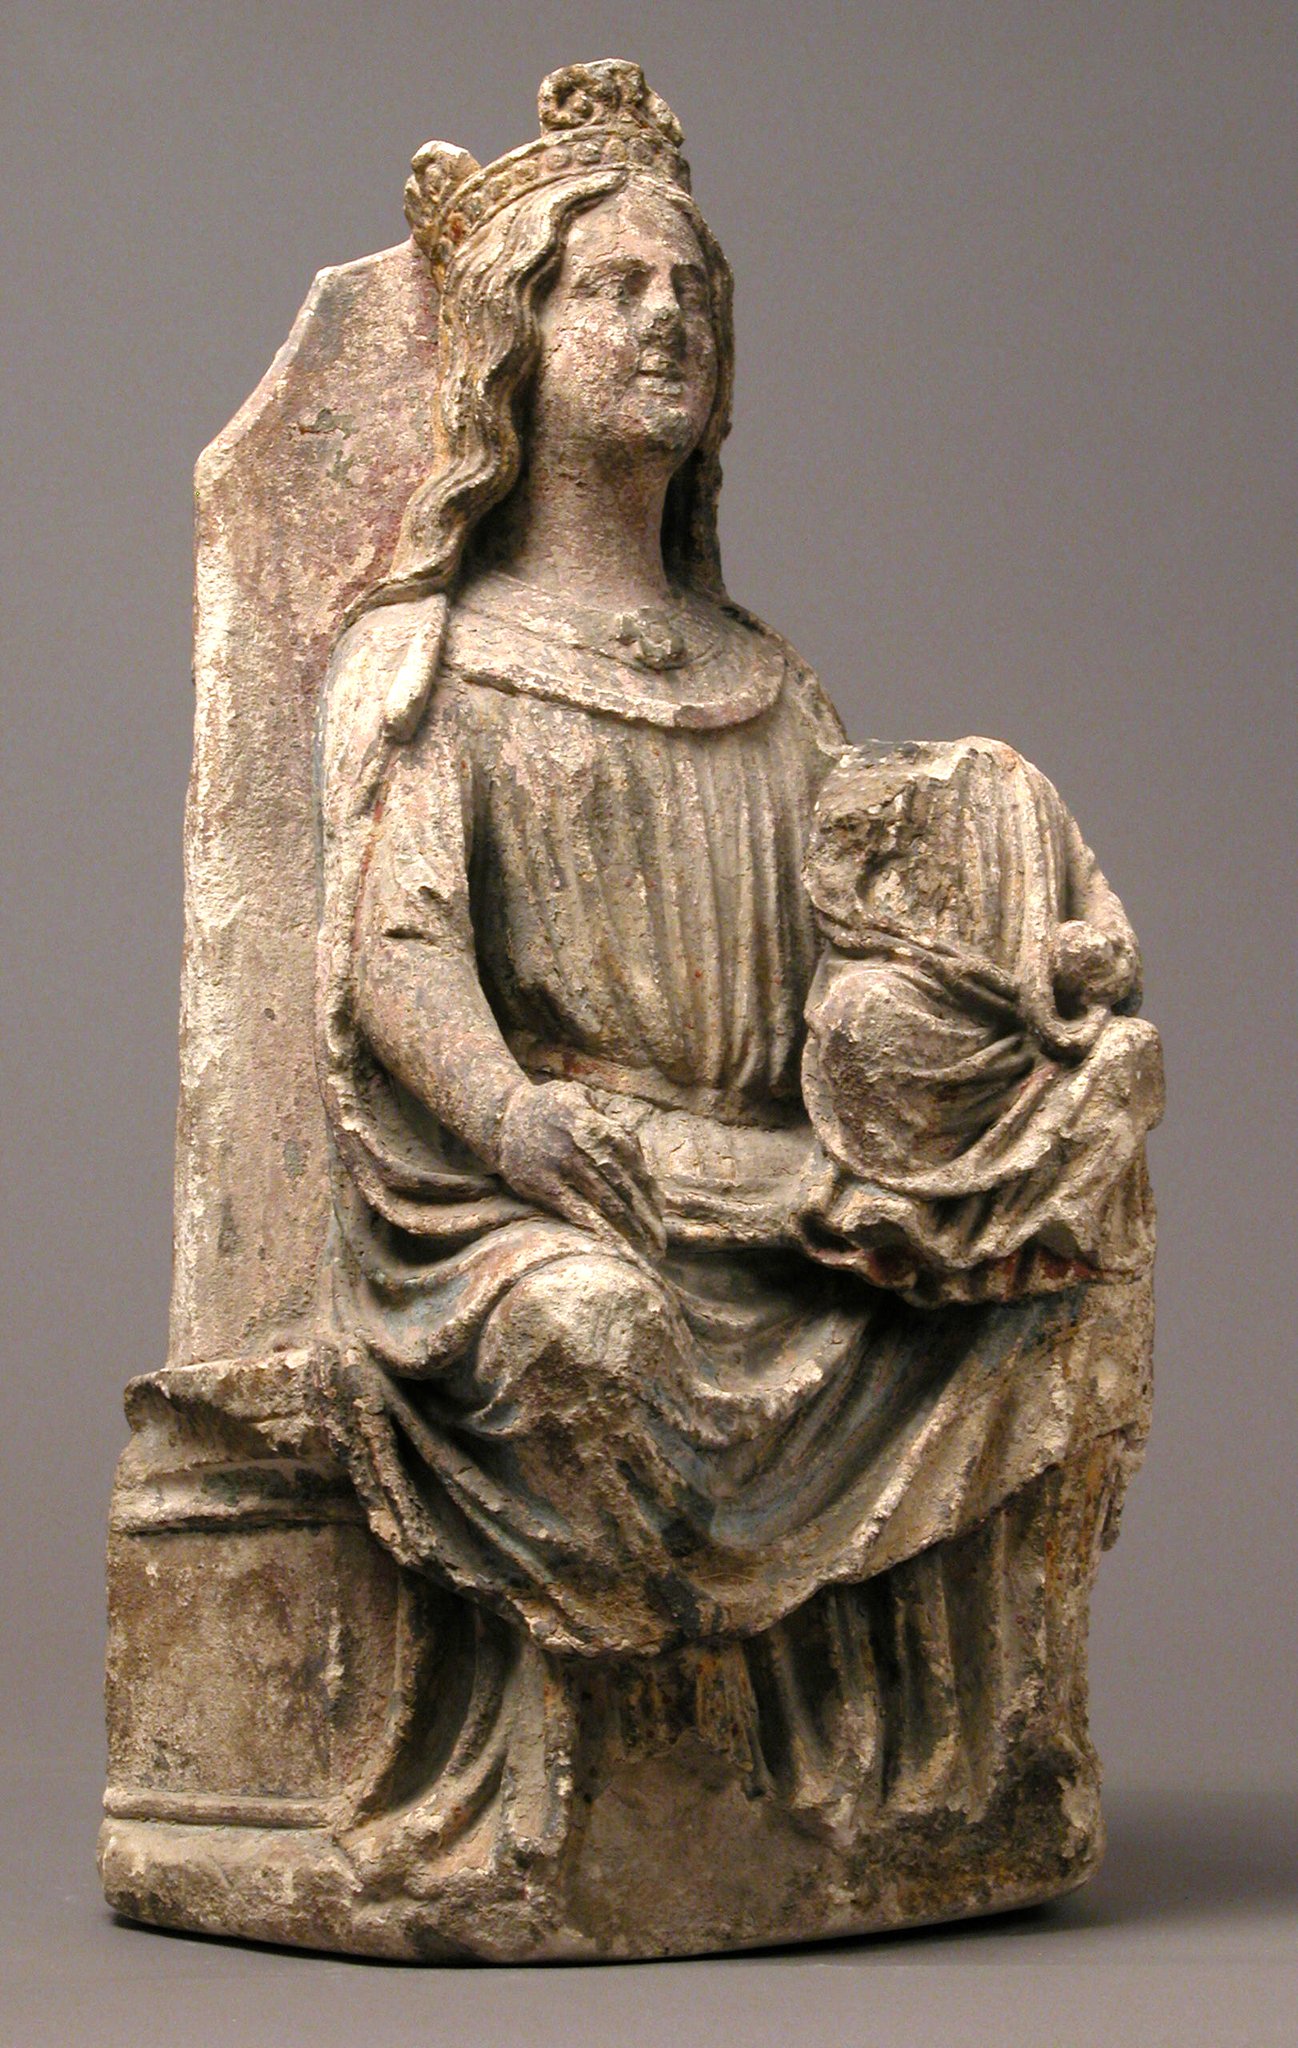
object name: statuette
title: Virgin and Child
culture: french or german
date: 1220-1230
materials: limestone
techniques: polychromy